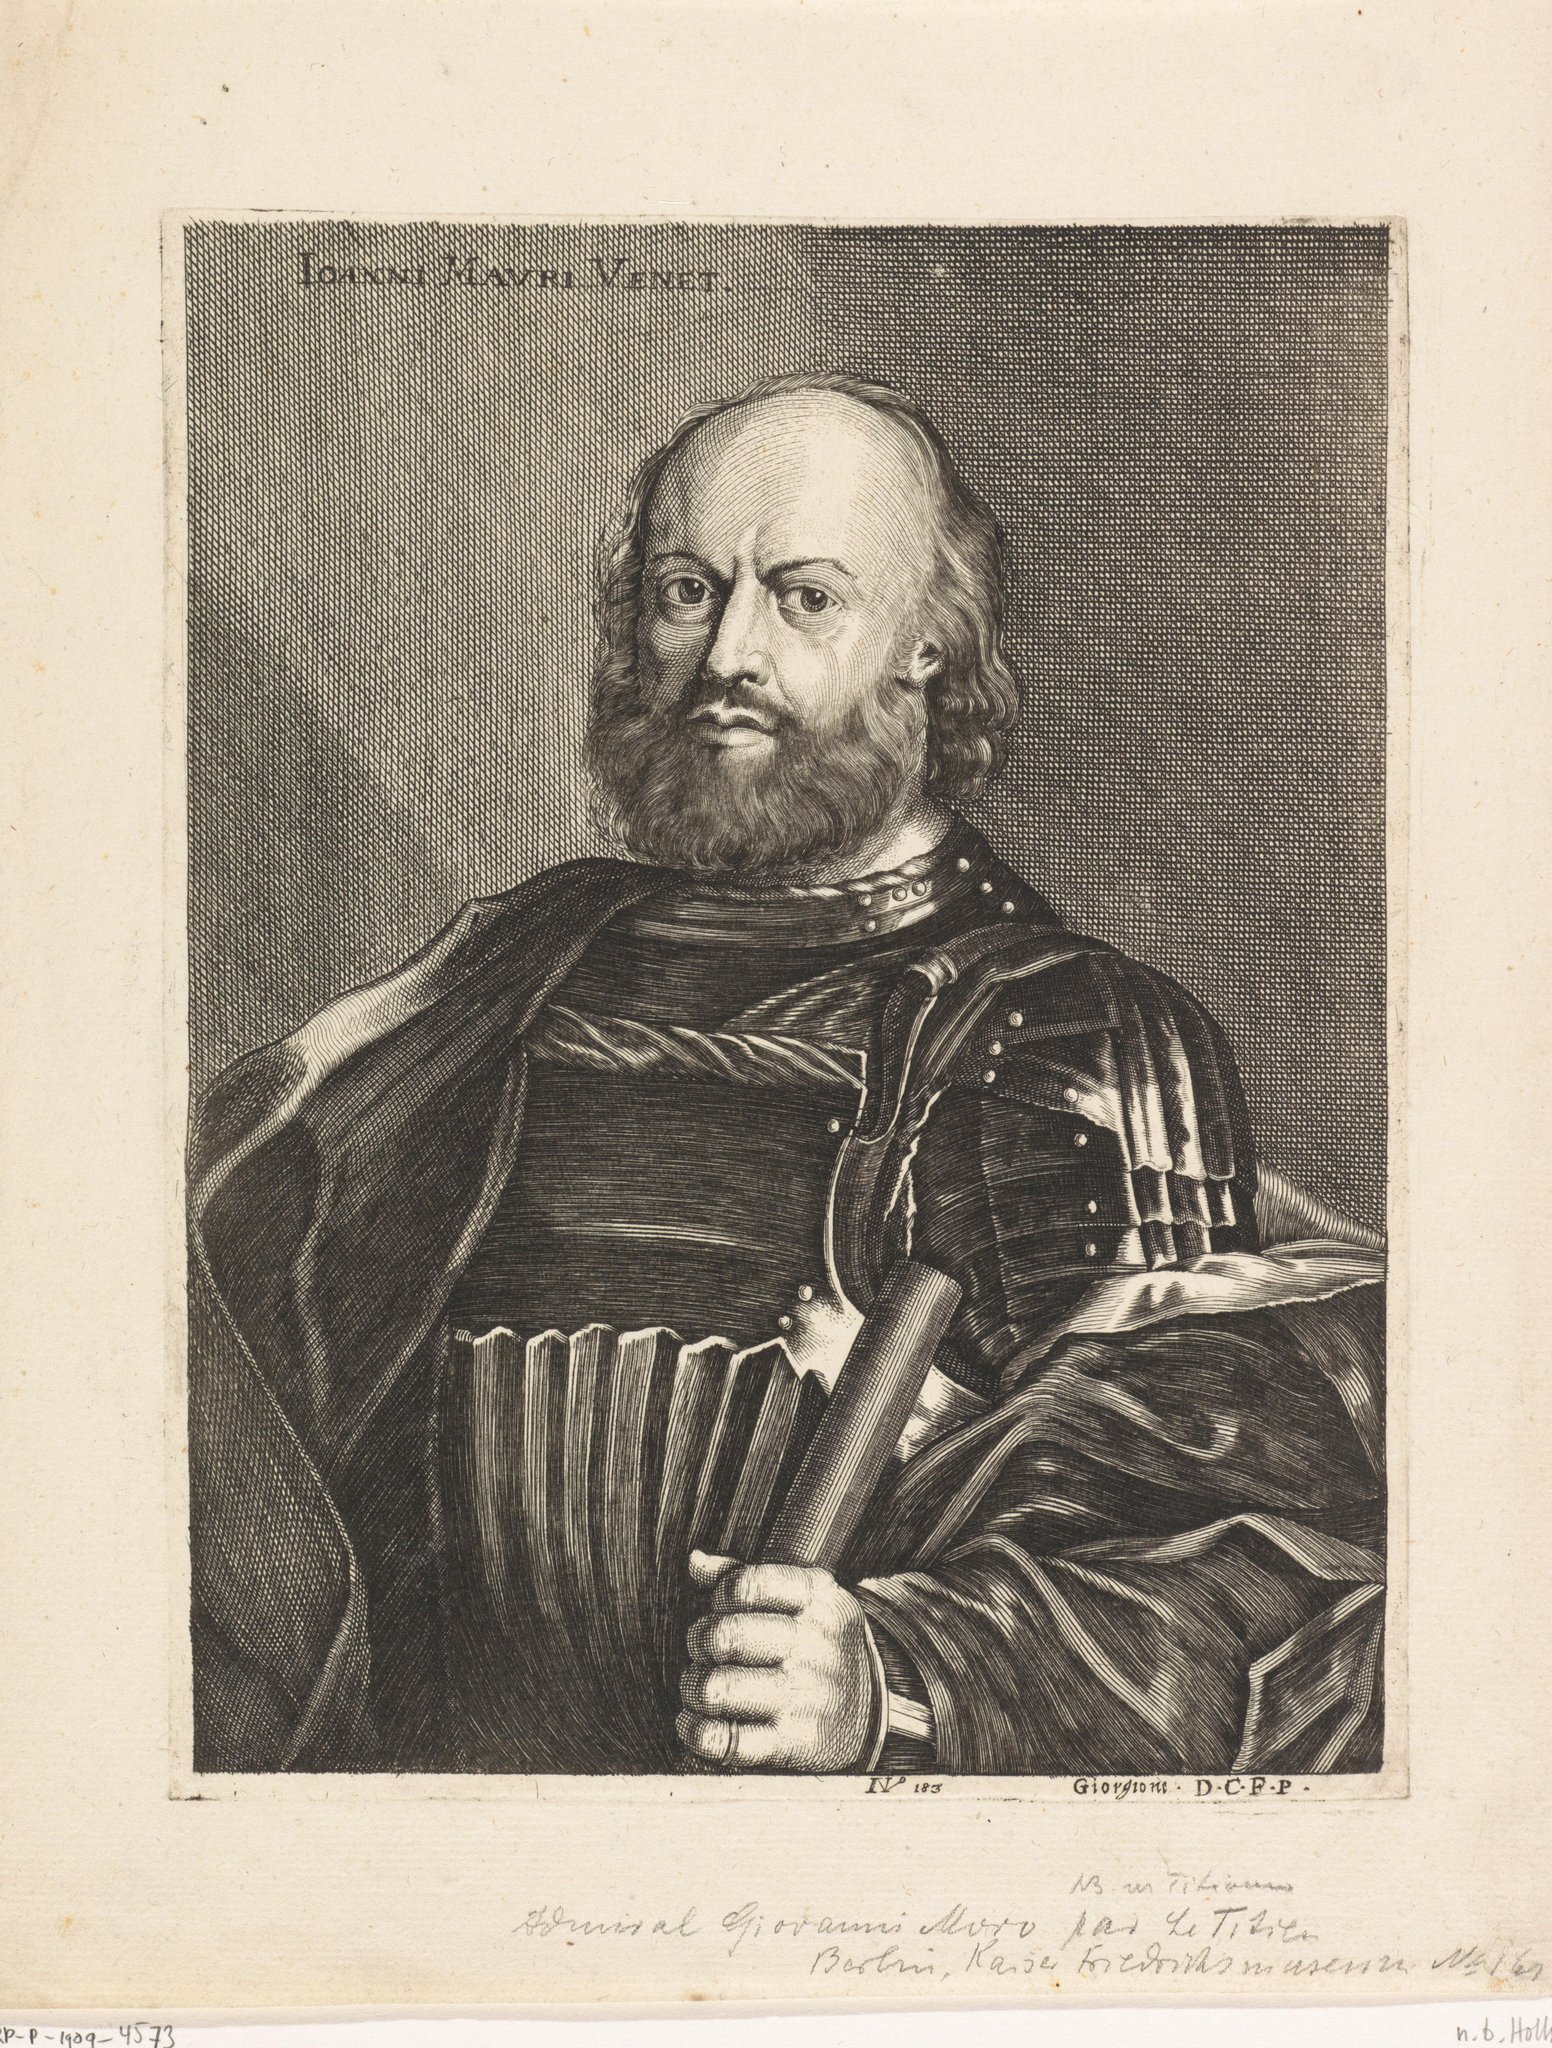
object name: print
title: Portret van een Venetiaanse man met commandostaf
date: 1650-1700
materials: paper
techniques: engraving, etching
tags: baton of general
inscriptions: collector's mark: Lugt 2228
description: Portret van een Venetiaanse man met commandostaf. Mogelijk de admiraal Giovanni Moro.